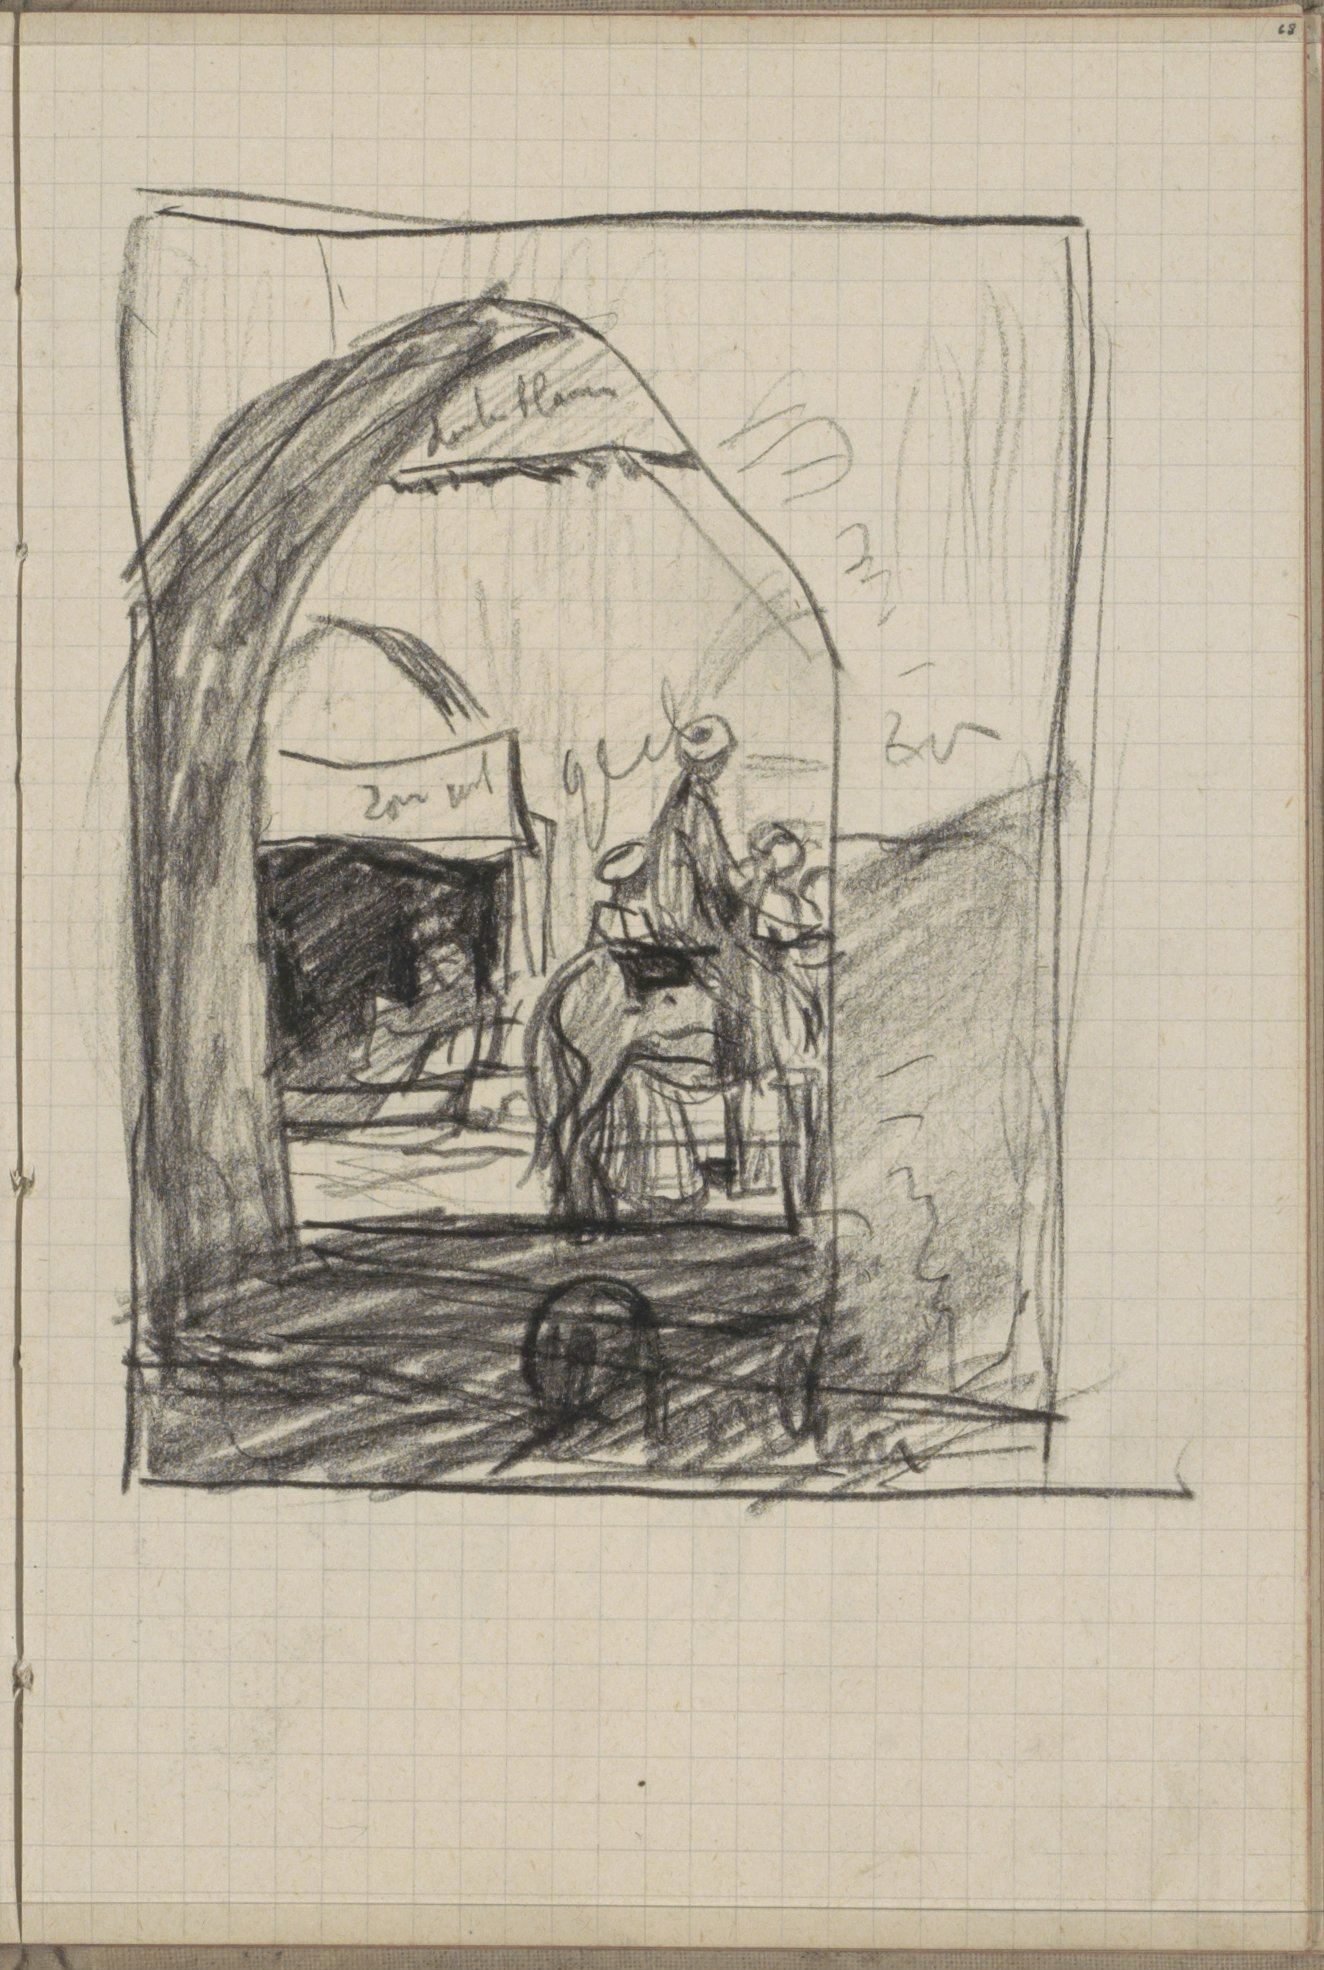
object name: sketchbook leaf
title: Ruiter en figuren gezien door een portaal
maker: marius bauer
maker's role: draughtsman, print maker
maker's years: 1867-1932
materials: chalk, paper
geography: istanbul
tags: riding a horse, ass, or mule; rider, horseman, arch, archivolt ~ architecture, street (+ city(-scape) with figures, staffage)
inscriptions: kleurnotitie, handgeschreven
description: Figuren in oosterse kleding. Pagina 68 uit een schetsboek met 51 bladen.